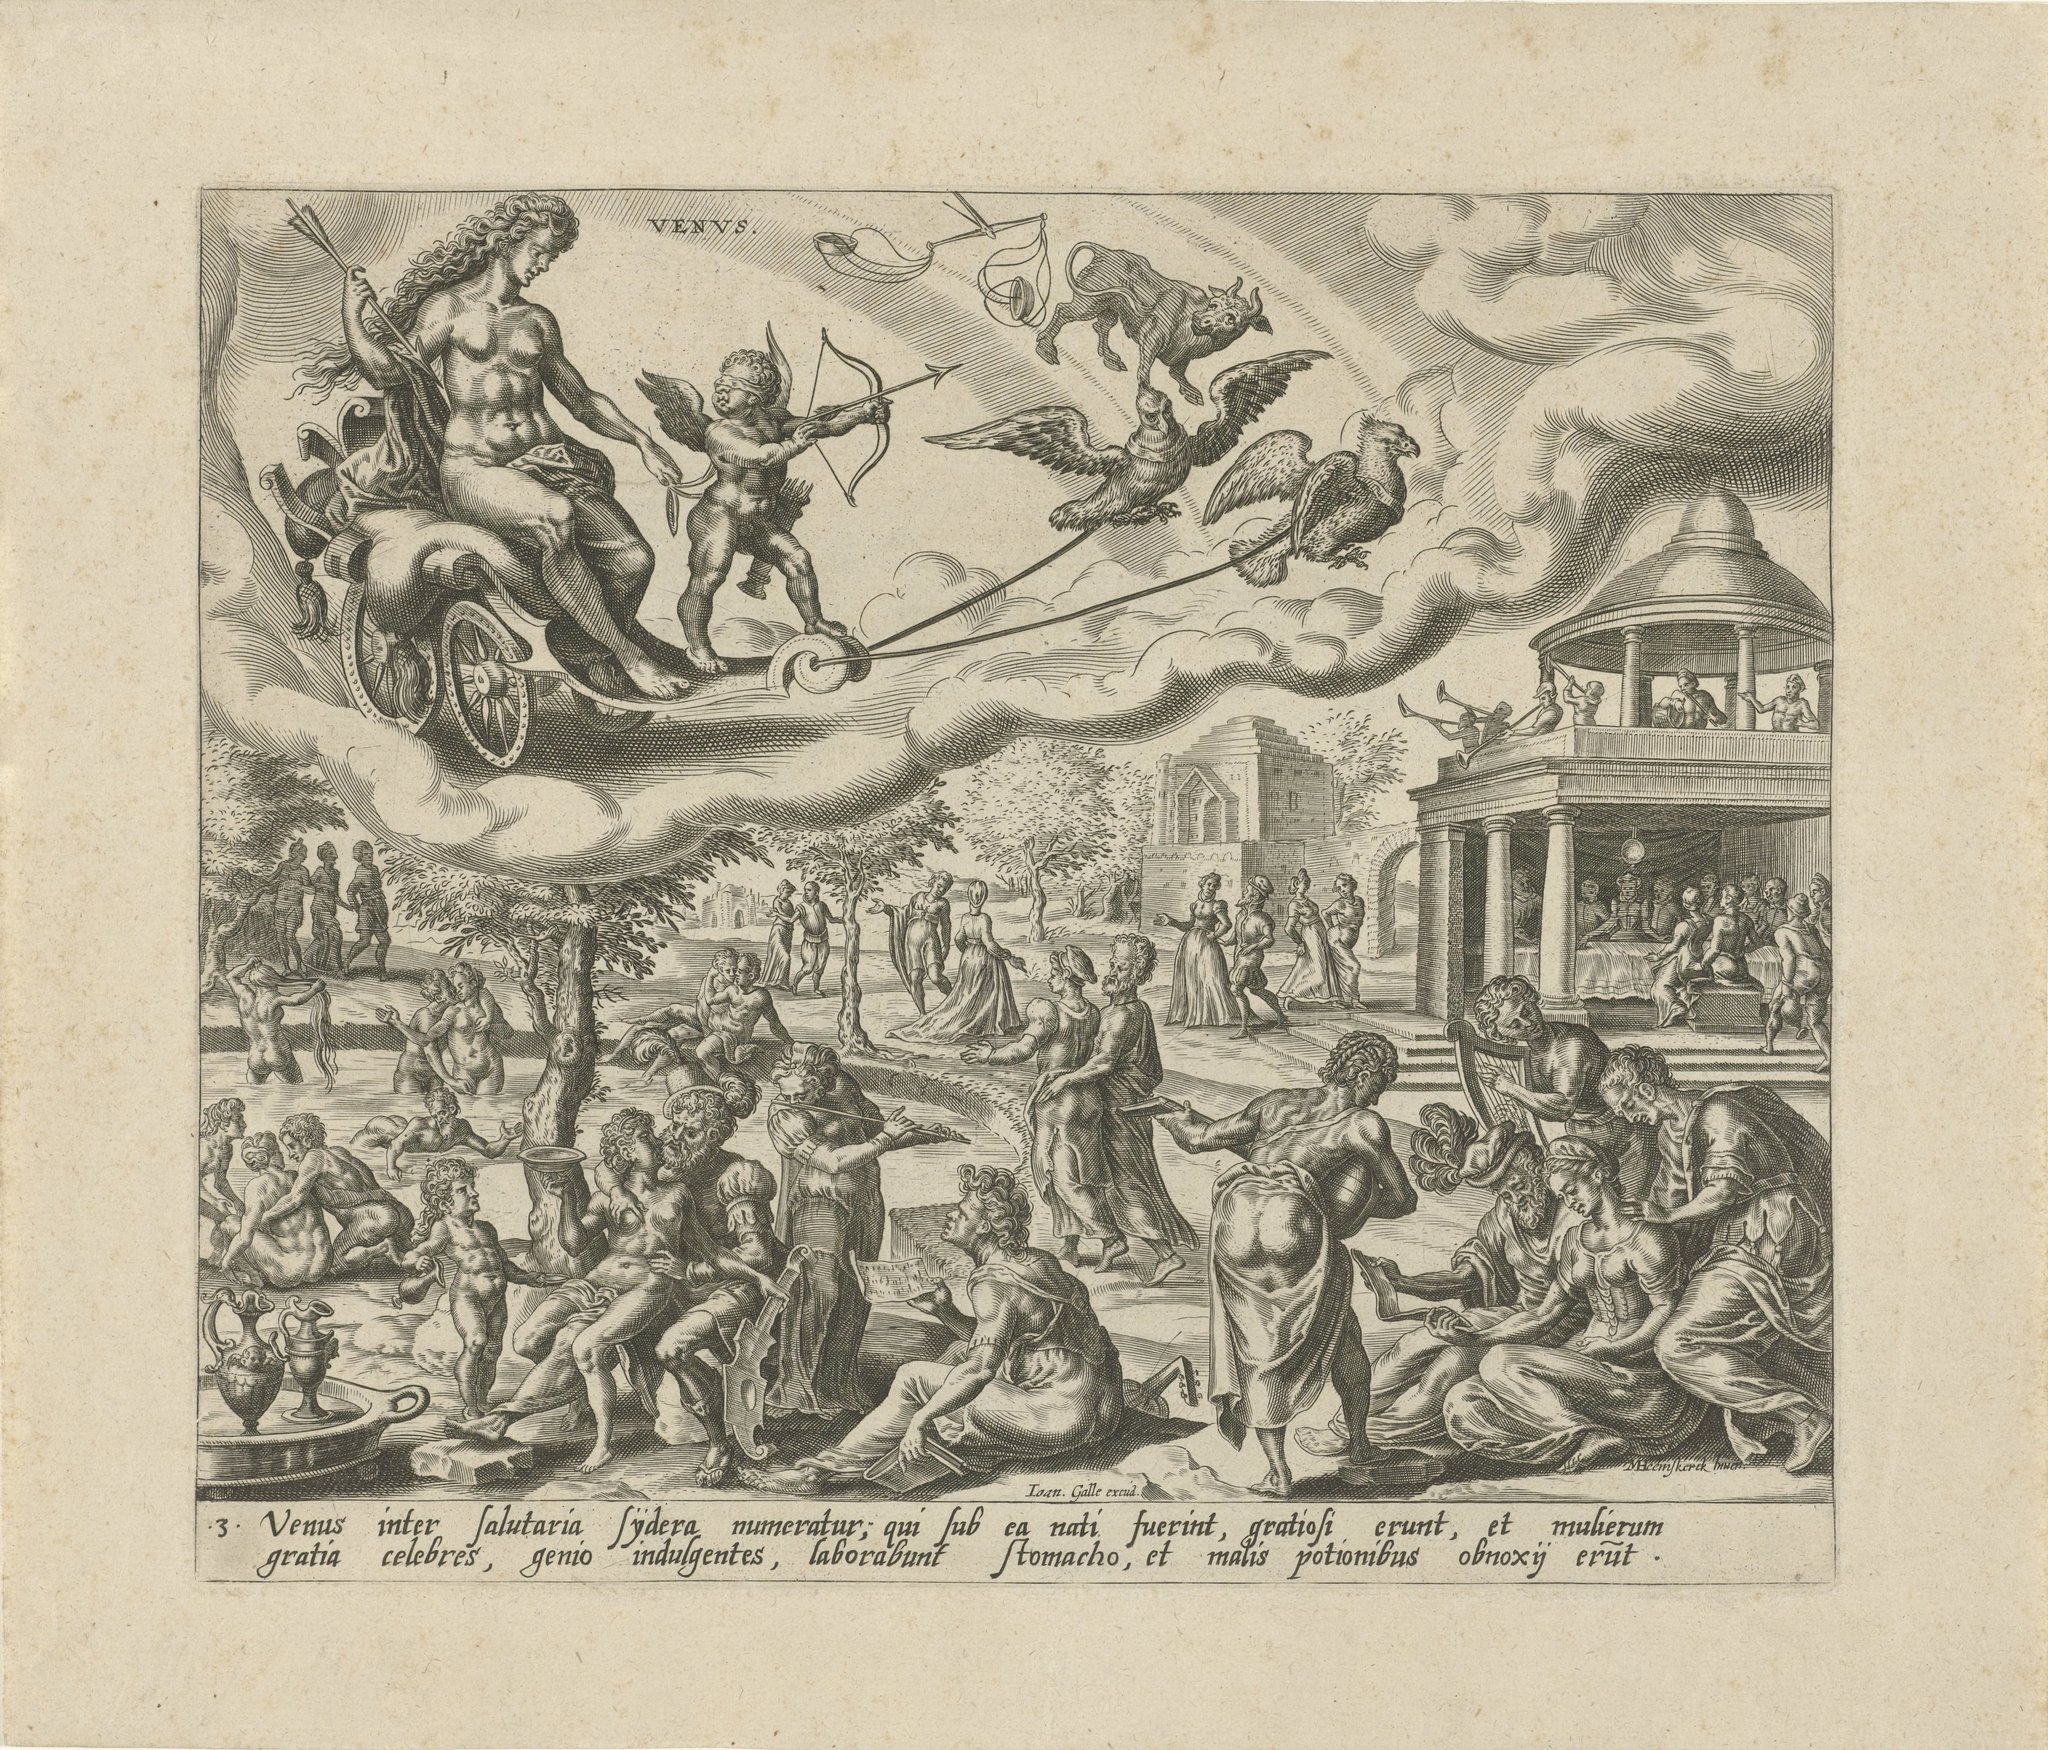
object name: print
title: De planeet Venus en haar kinderen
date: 1566-1570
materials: paper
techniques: engraving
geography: antwerp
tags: making music; musician with instrument, venus and her children ('planetenkinder') ~ taurus and libra, eating and drinking, taking a bath - aa - in the open air, (lovers) caressing each other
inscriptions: collector's mark: Lugt 2228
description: Prent mogelijk gebruikt in: Speculum diversarum imaginum speculativarum a variis doctis adinventarum, atque ab insignibus pictoribus ac sculptoribus delineatarum. Antwerpen: Johannes Galle, 1638. Of in: Schabaelje, Jan Philipsz. Den grooten figver-bibel. Dat is een afbeeldingh en levendighe vertooningh, van alle de voornaemste historien (...) der gantscher Heyliger Schrift, in schoone copere figueren (...) verrijckt met leersame verclaeringhen over de selve figueren. Alkmaar: Simon Cornelisz Brekegeest, Amsterdam: Jan Philipsz. Schabaelje, 1646.